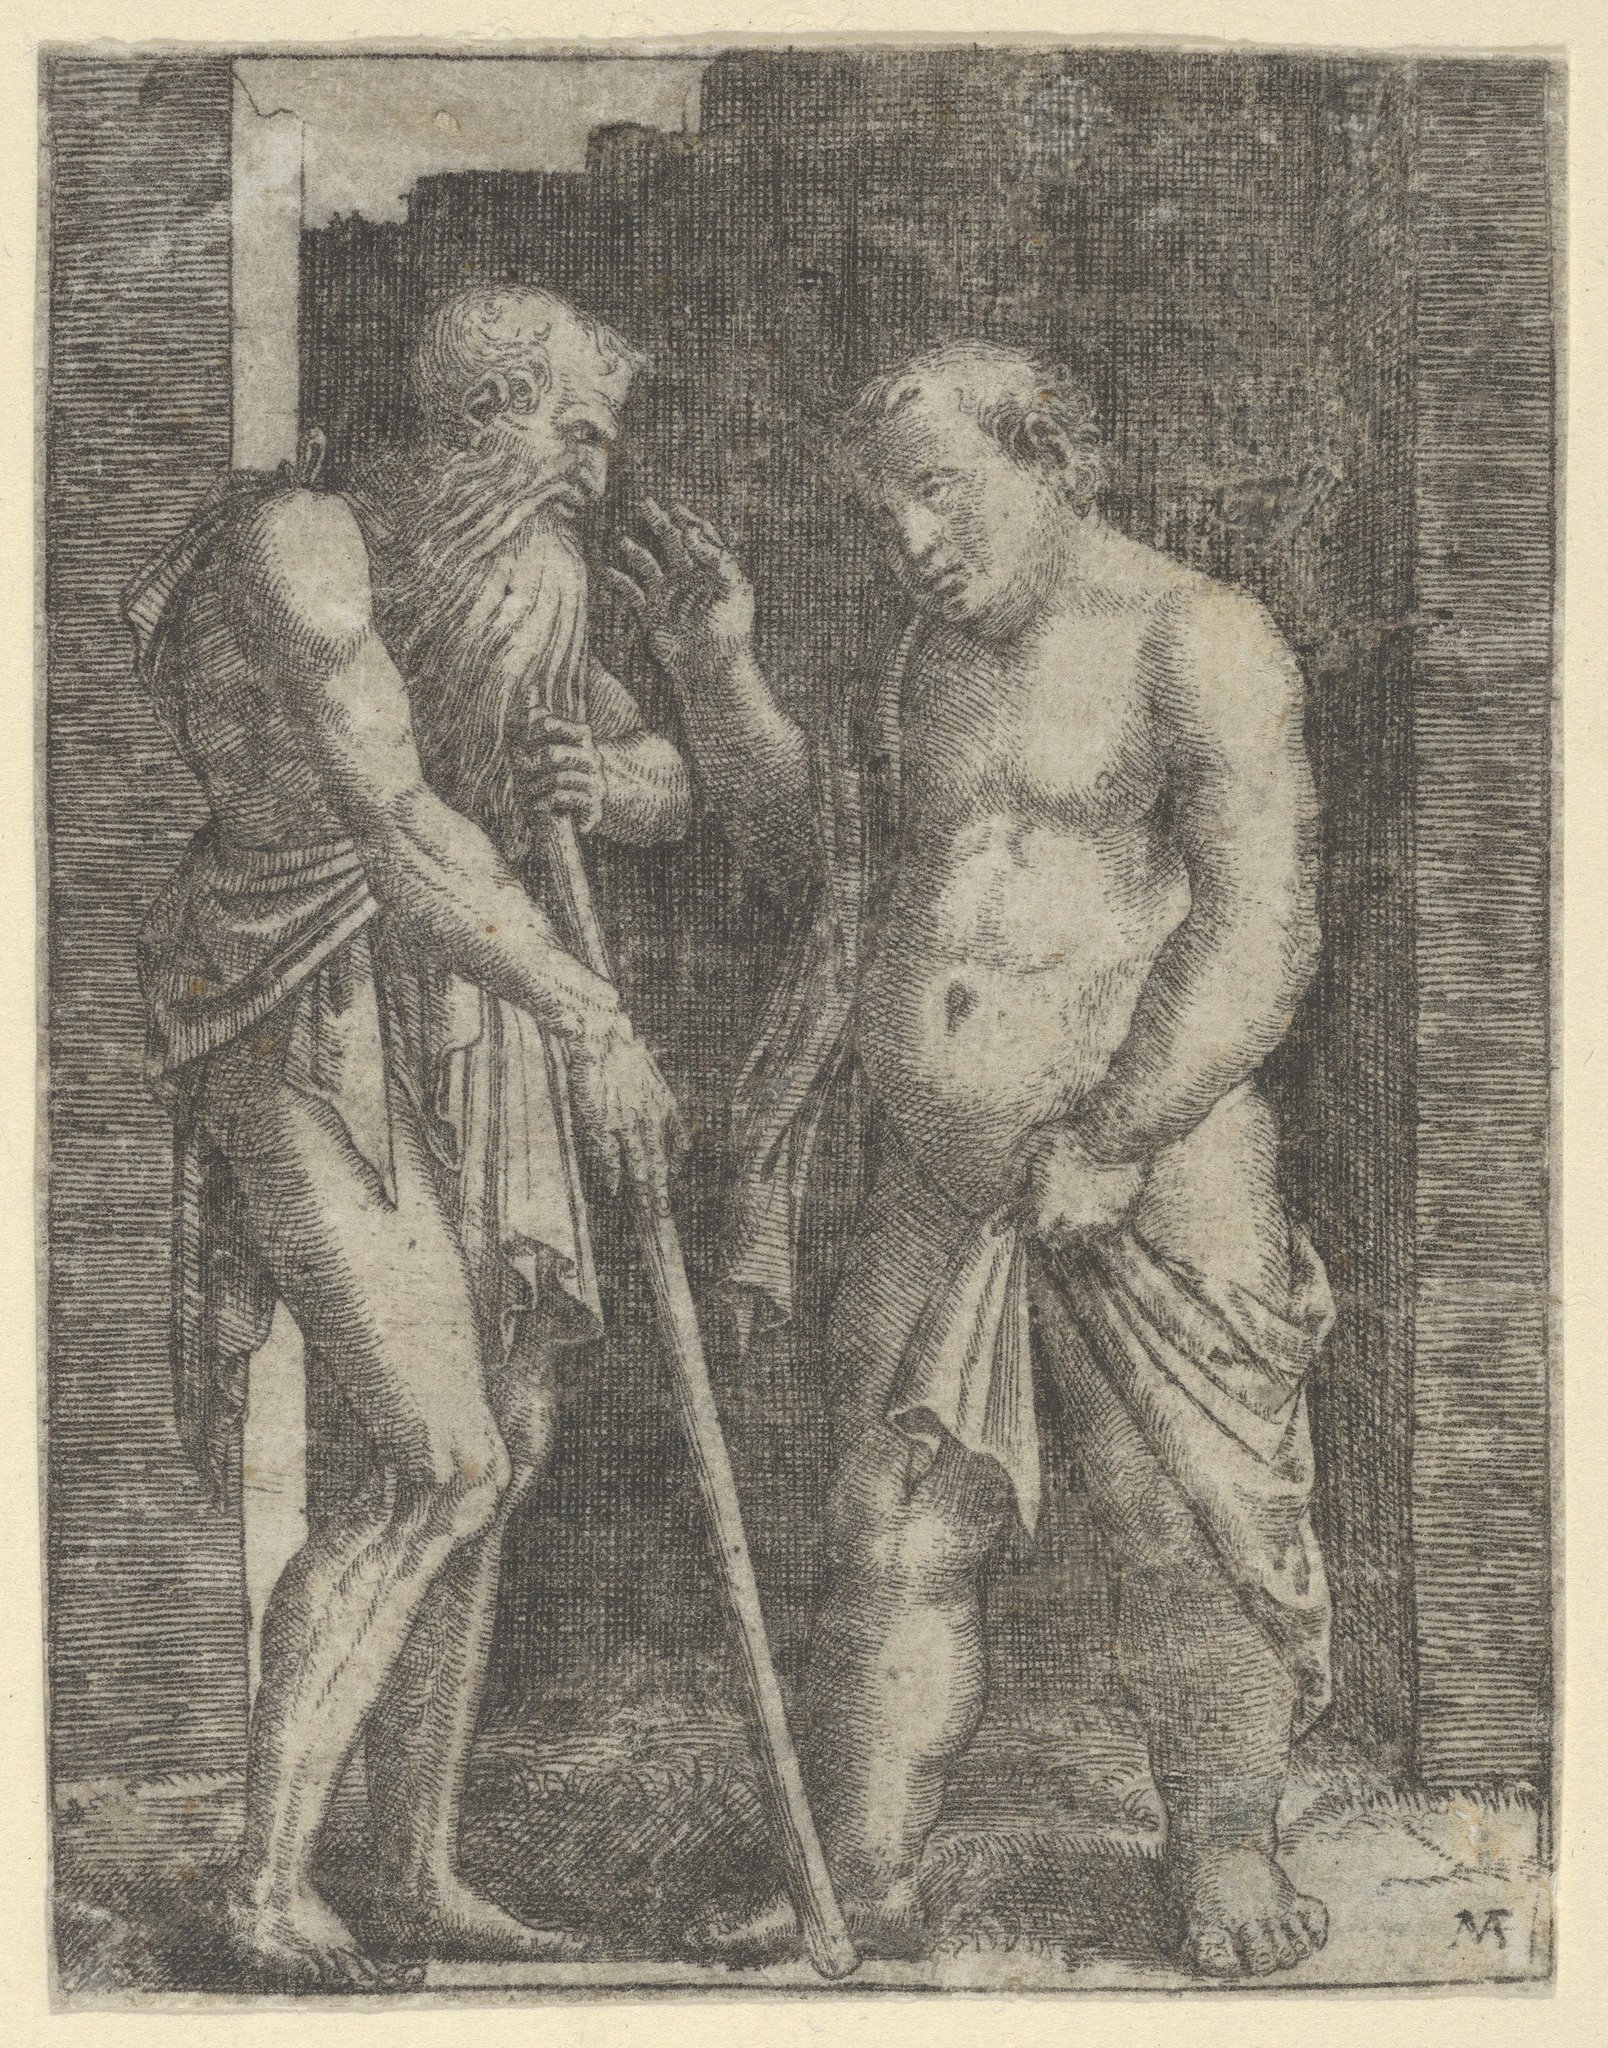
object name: print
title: An old skinny man at left talking with a fat man at right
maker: marcantonio raimondi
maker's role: artist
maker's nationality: italian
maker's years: 1475-1534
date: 1510-1527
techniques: engraving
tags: men